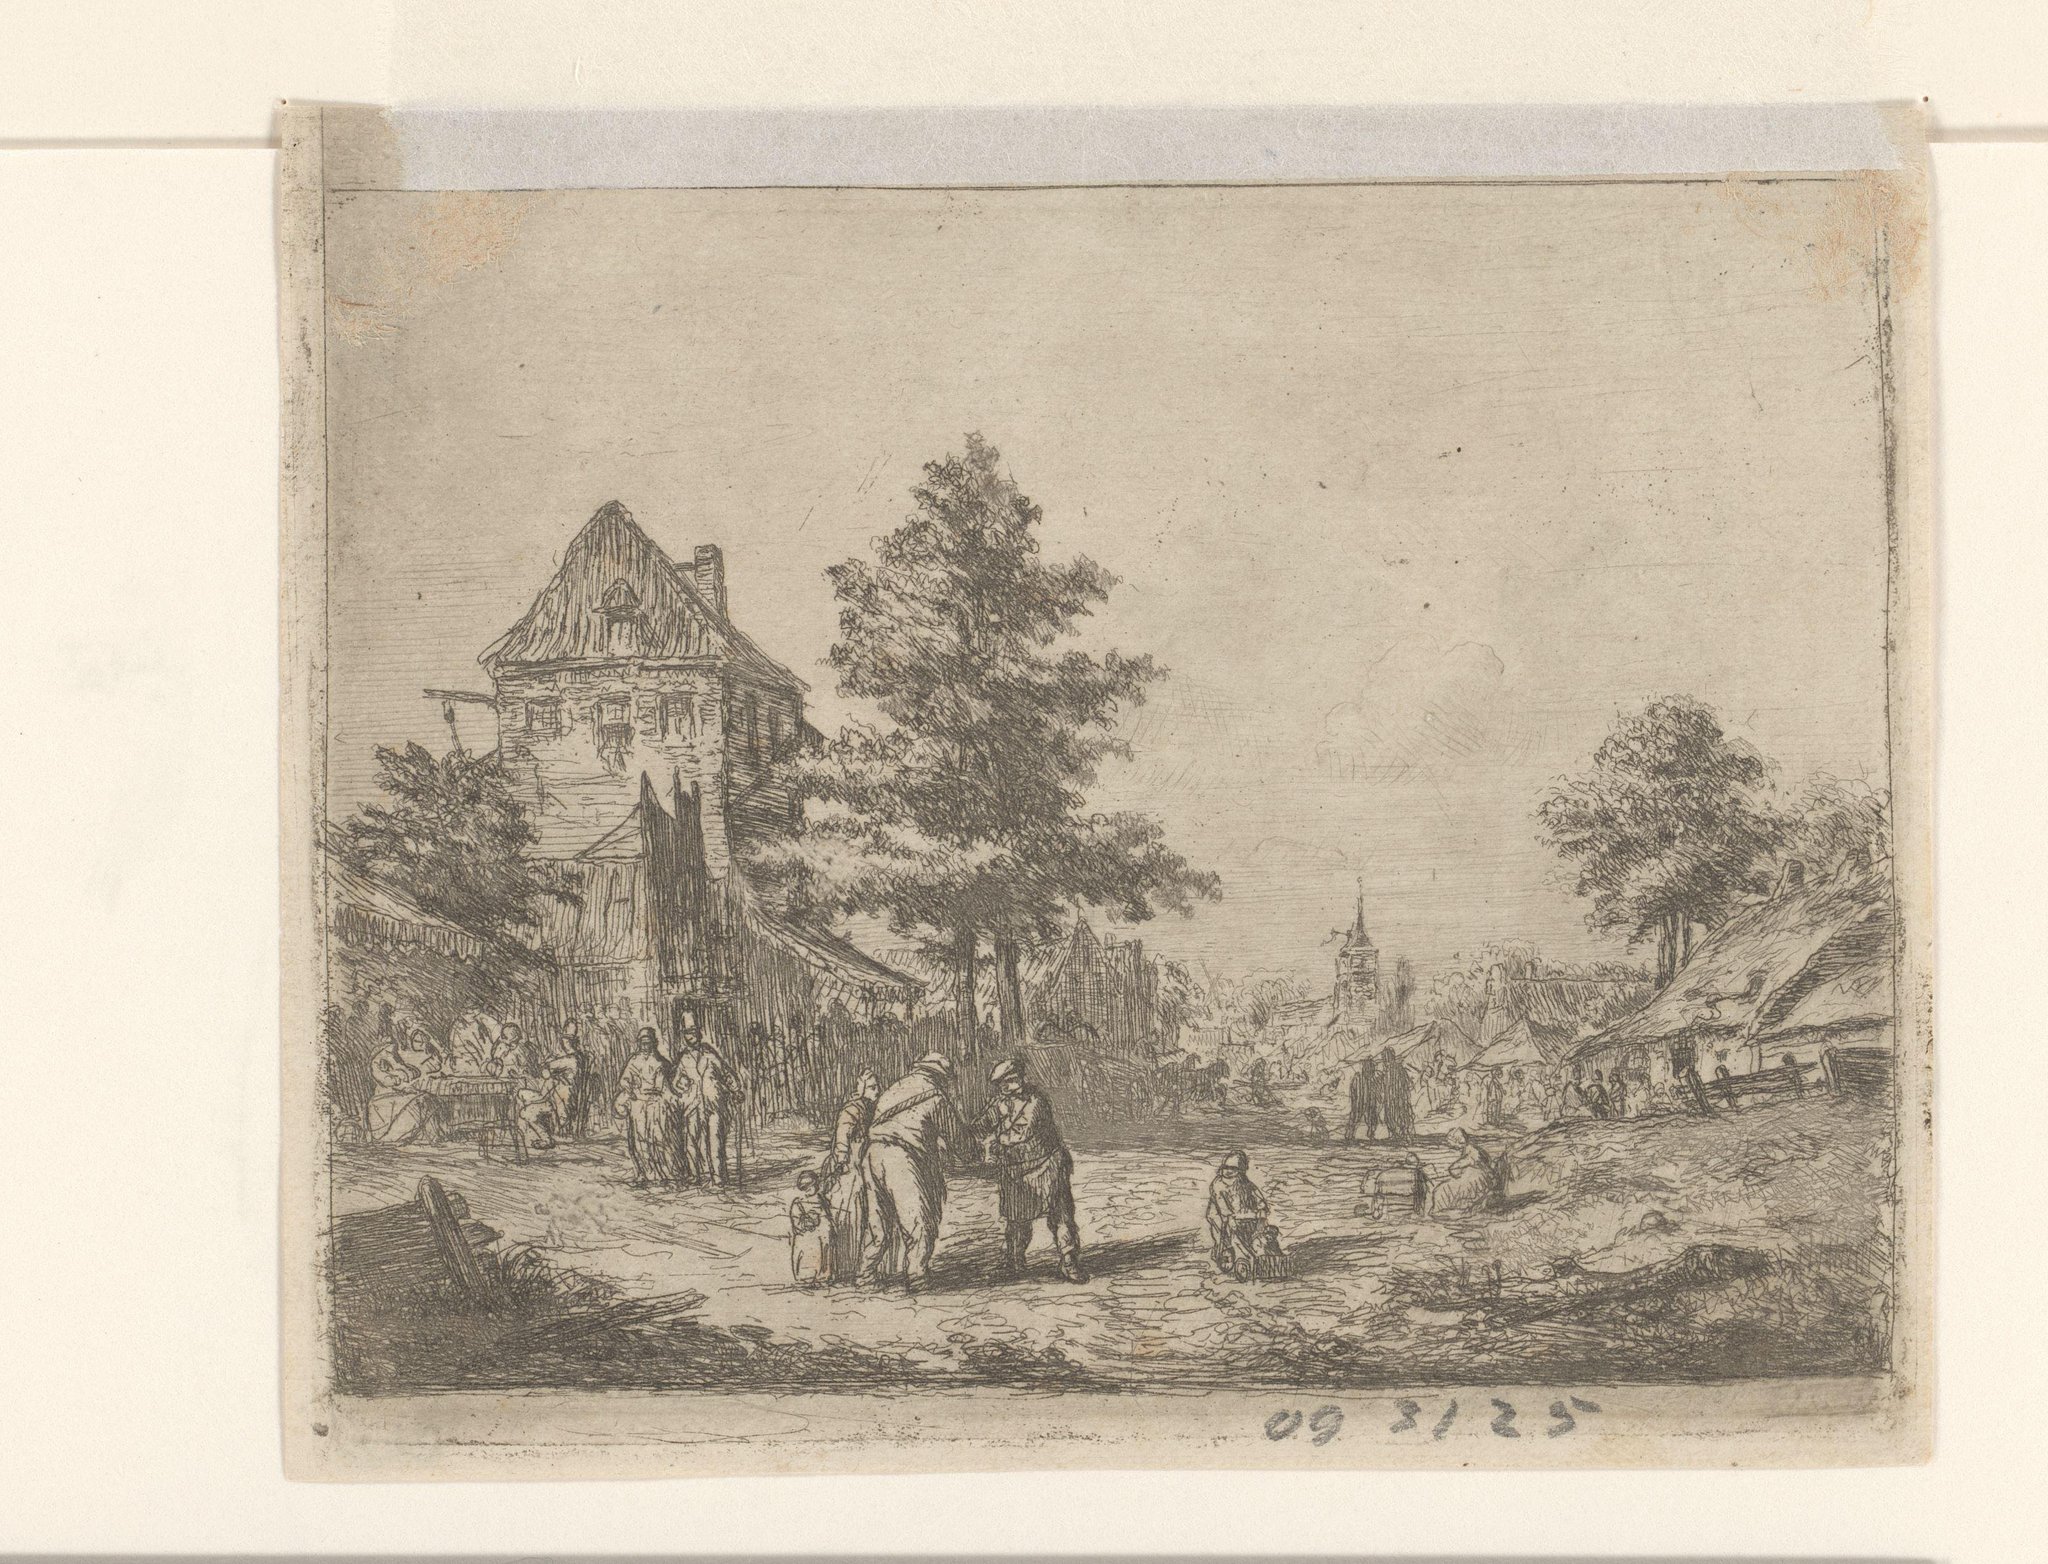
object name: print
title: Dorpsgezicht met veel mensen op straat en een kerk op de achtergrond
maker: florent nicolas crabeels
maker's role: print maker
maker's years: 1829-1896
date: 1849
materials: paper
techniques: etching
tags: village, public festivities